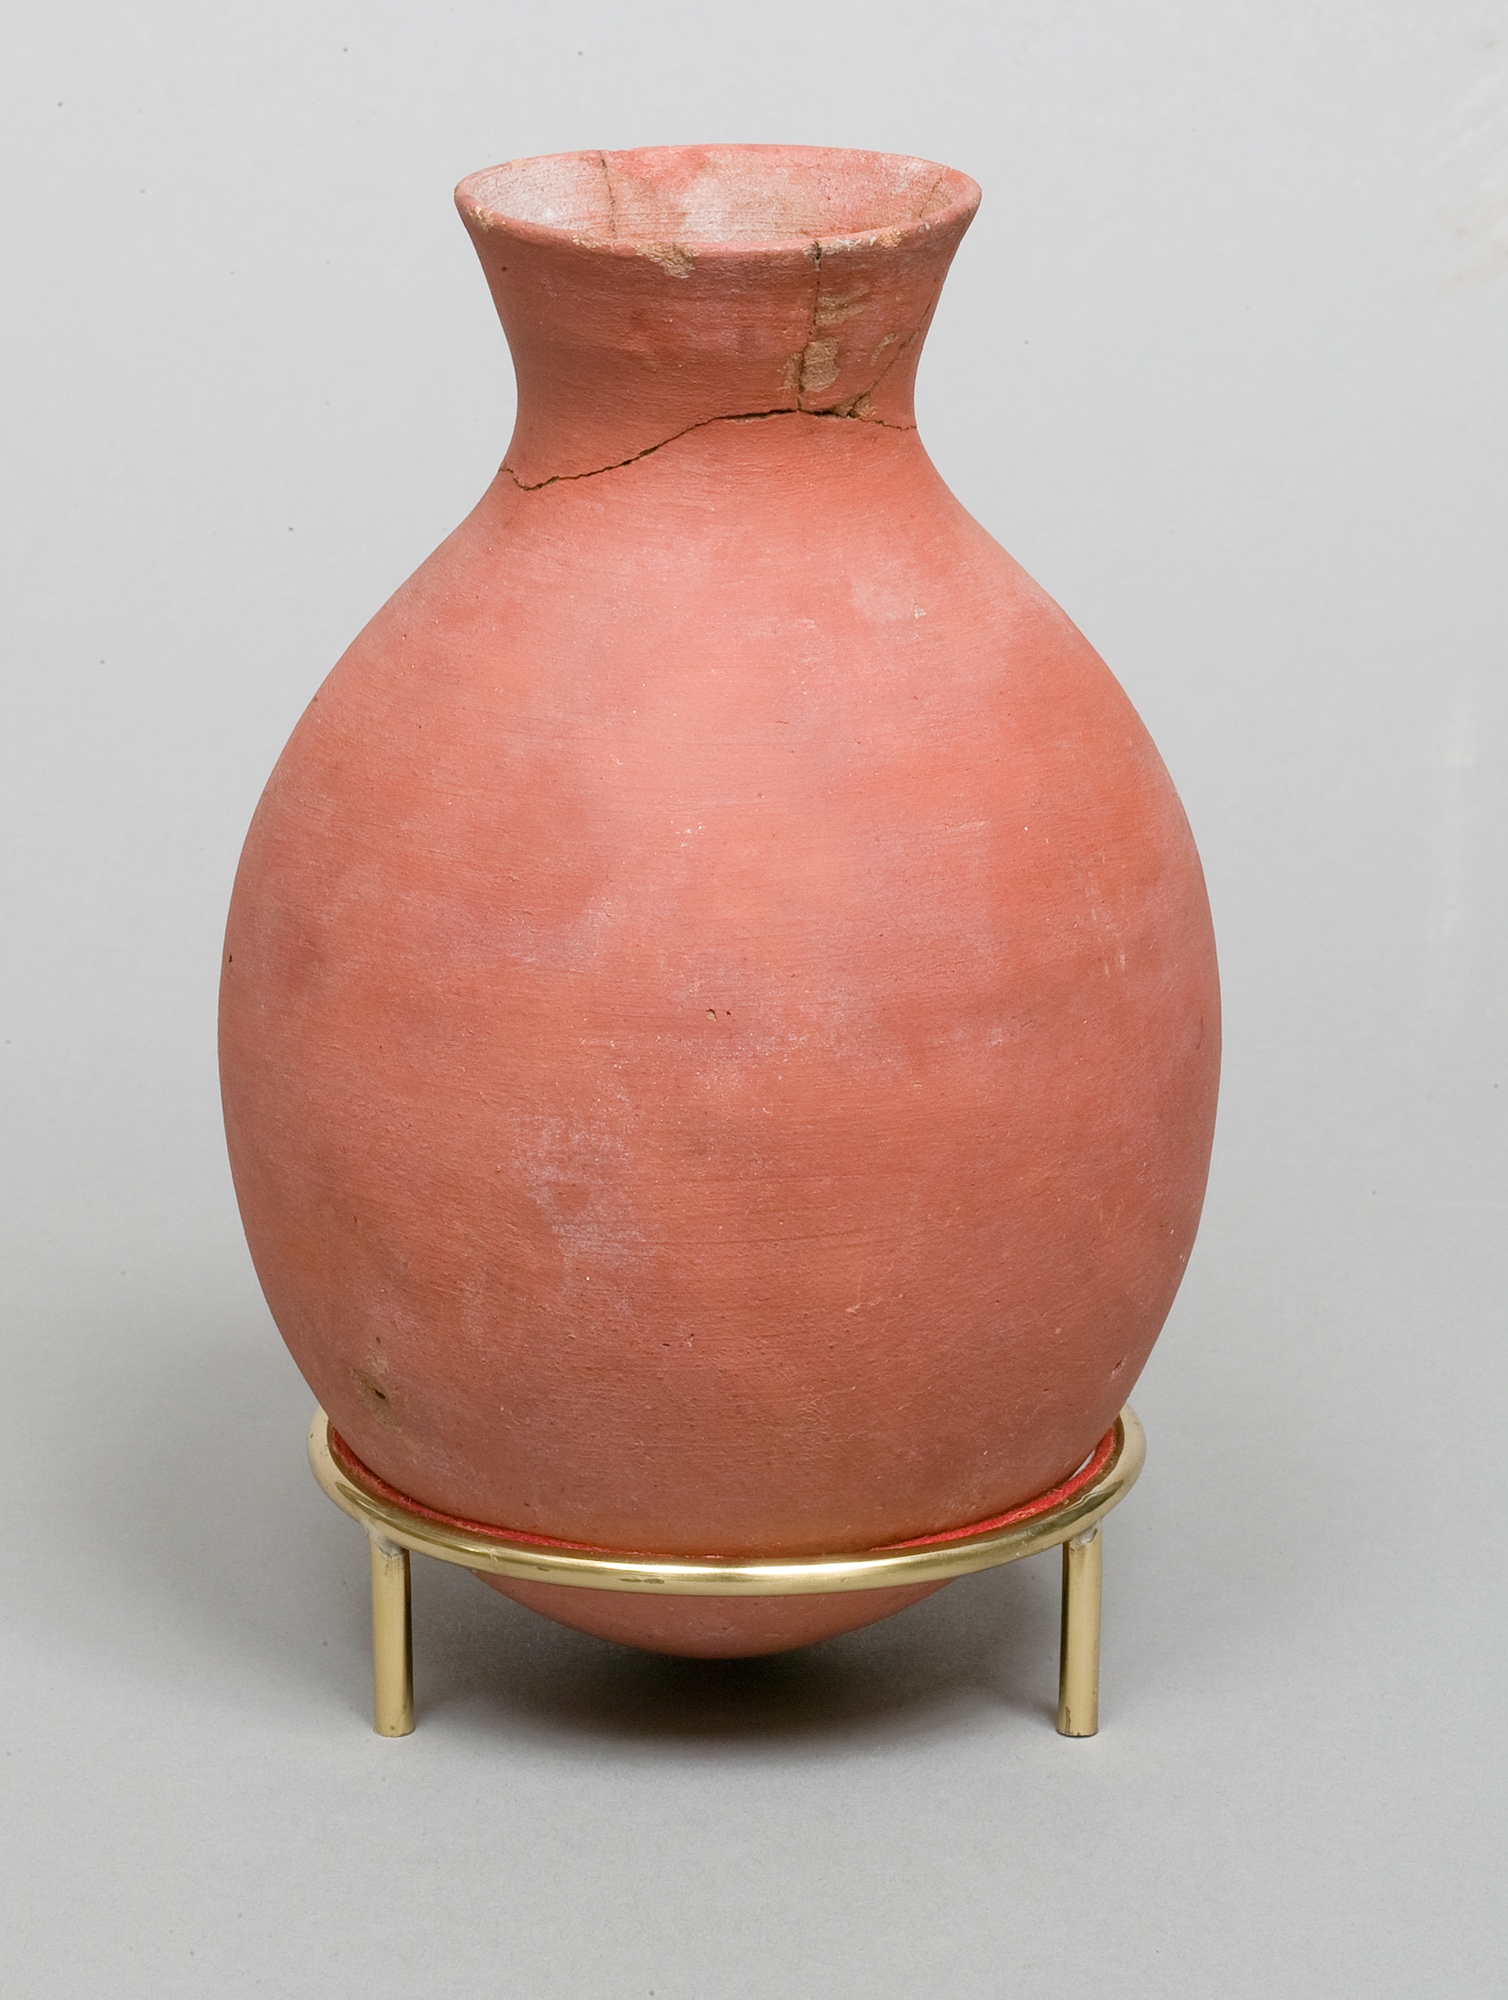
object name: bottle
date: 1900-1800 BCE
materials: clay, pottery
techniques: wash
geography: egypt